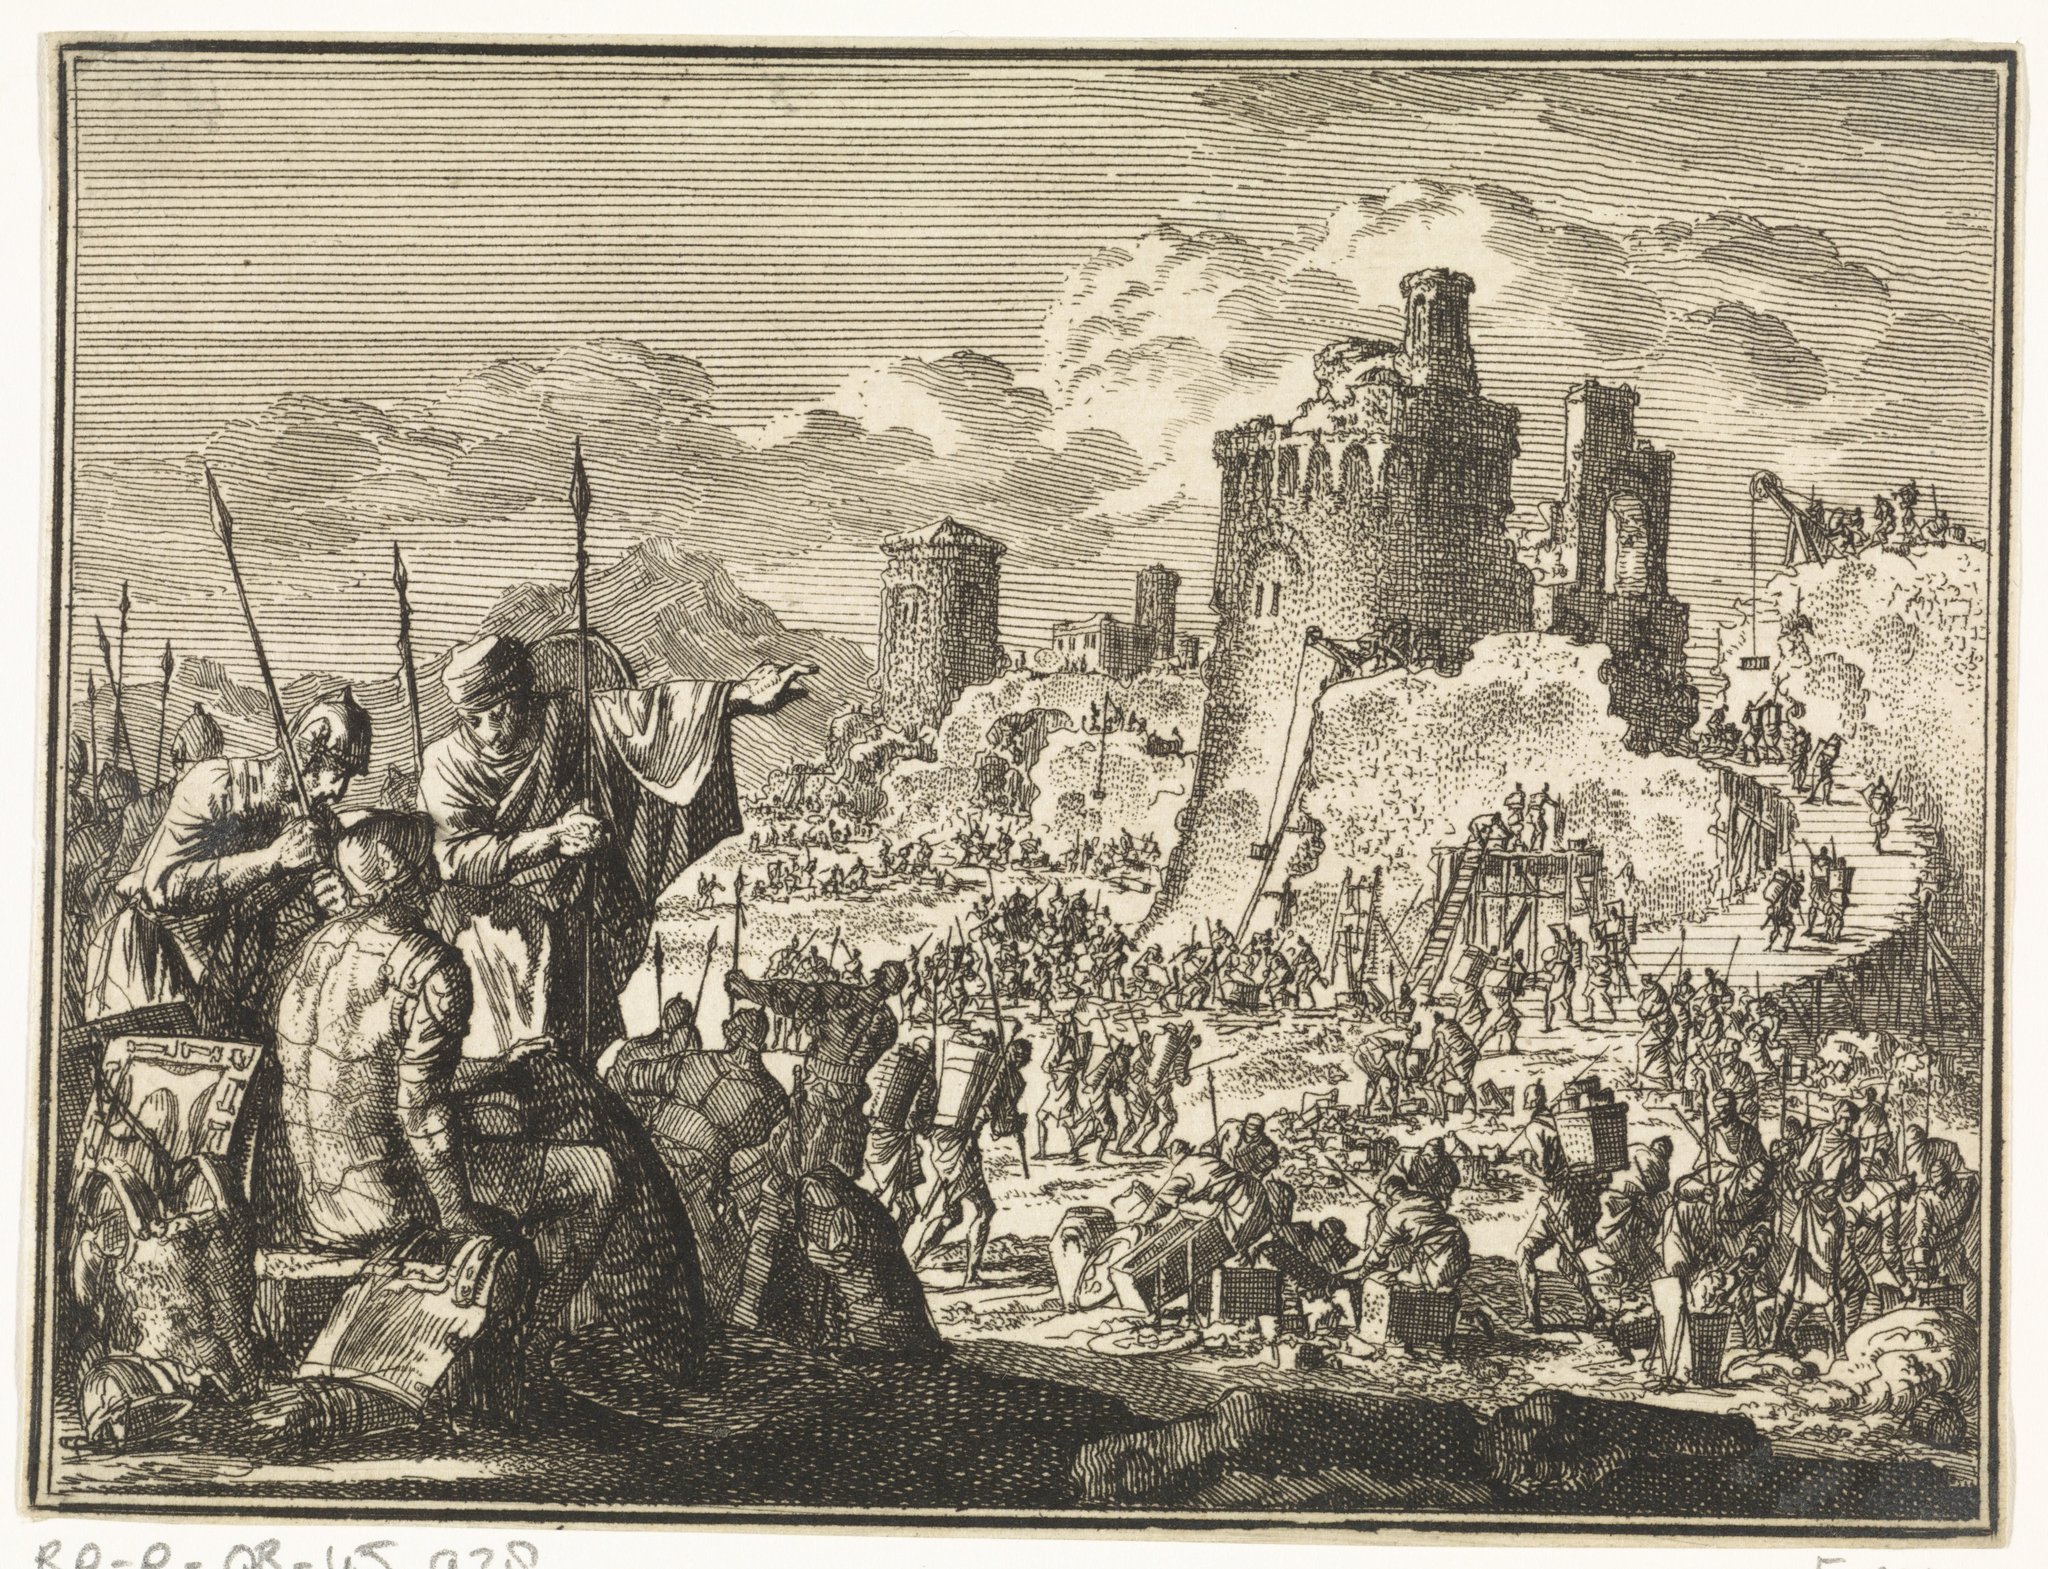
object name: print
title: Herbouw van de muren van Jeruzalem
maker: jan luyken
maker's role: draughtsman, print maker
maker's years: 1649-1712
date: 1712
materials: paper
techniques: etching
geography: amsterdam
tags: the rebuilding of jerusalem's walls (nehemiah 2:12 - 4; 6)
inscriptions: collector's mark: Lugt 2228, number: ‘184’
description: Illustratie uit: Luyken, Jan. De schriftuurlyke geschiedenissen en gelykenissen van het Oude en Nieuwe Verbond, 2 delen. Amsterdam: Wed. Pieter Arentsz II en Cornelis van der Sys, 1712, dl. I.